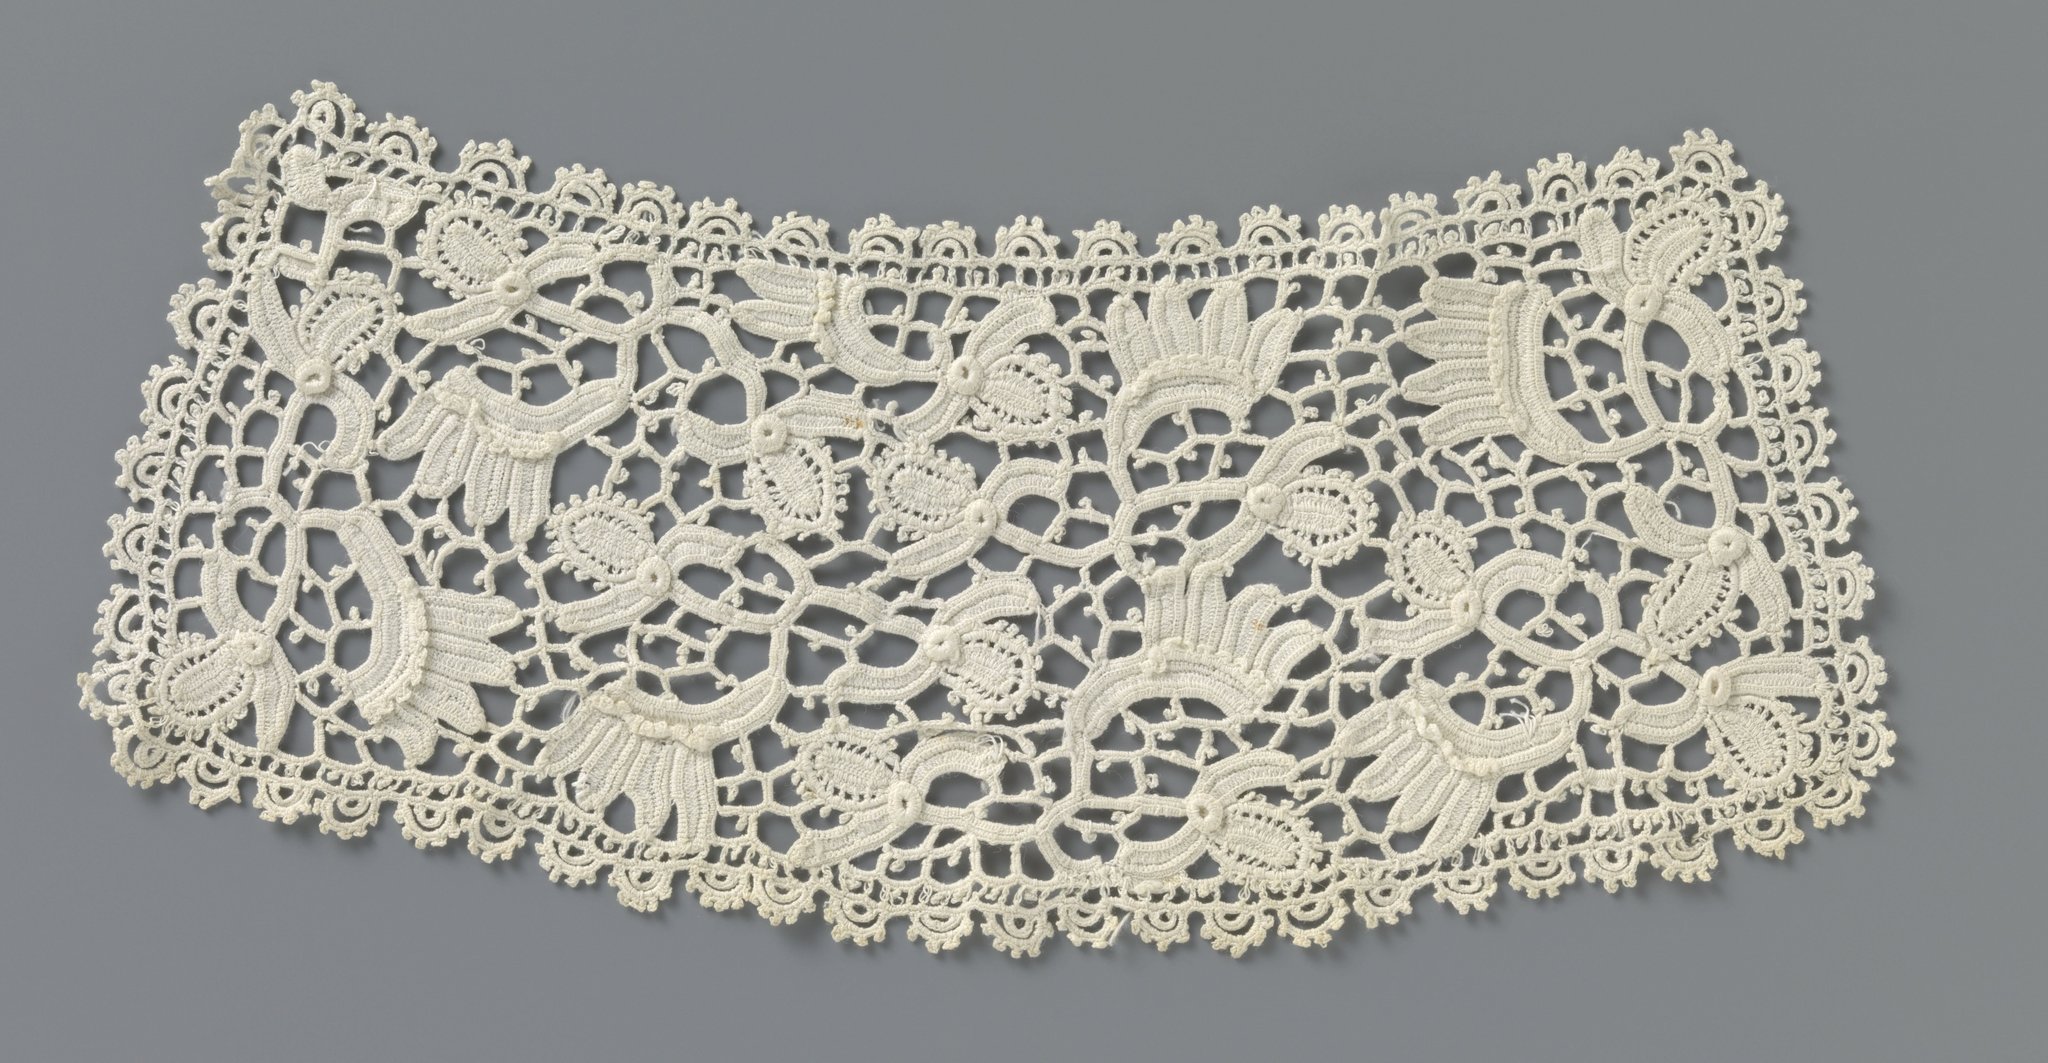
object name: cuff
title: Manchet van gehaakte kant met borstelachtige bladeren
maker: Anonymous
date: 1890-1909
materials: cotton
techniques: crocheted lace, irish crochet lace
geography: ireland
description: Het is een aanname dat deze Ierse gehaakte kant ook daadwerkelijk in Ierland is gemaakt. Ierse gehaakte kant kent zijn oorsprong rond 1760 en kwam vanaf 1840 in ontwikkeling. Aangezien volgens Martine Bruggeman (Kant in Europa) de Ierse haakindustrie aan het eind van de 19e eeuw gereorganiseerd werd en in populariteit groeide, is het hier beschreven stuk gedateerd rond 1890, tot 1909 vanwege de datering in het eerste decennium van populariteit van Ierse gehaakte kant volgens het Kantlexicon (Johan Coene).